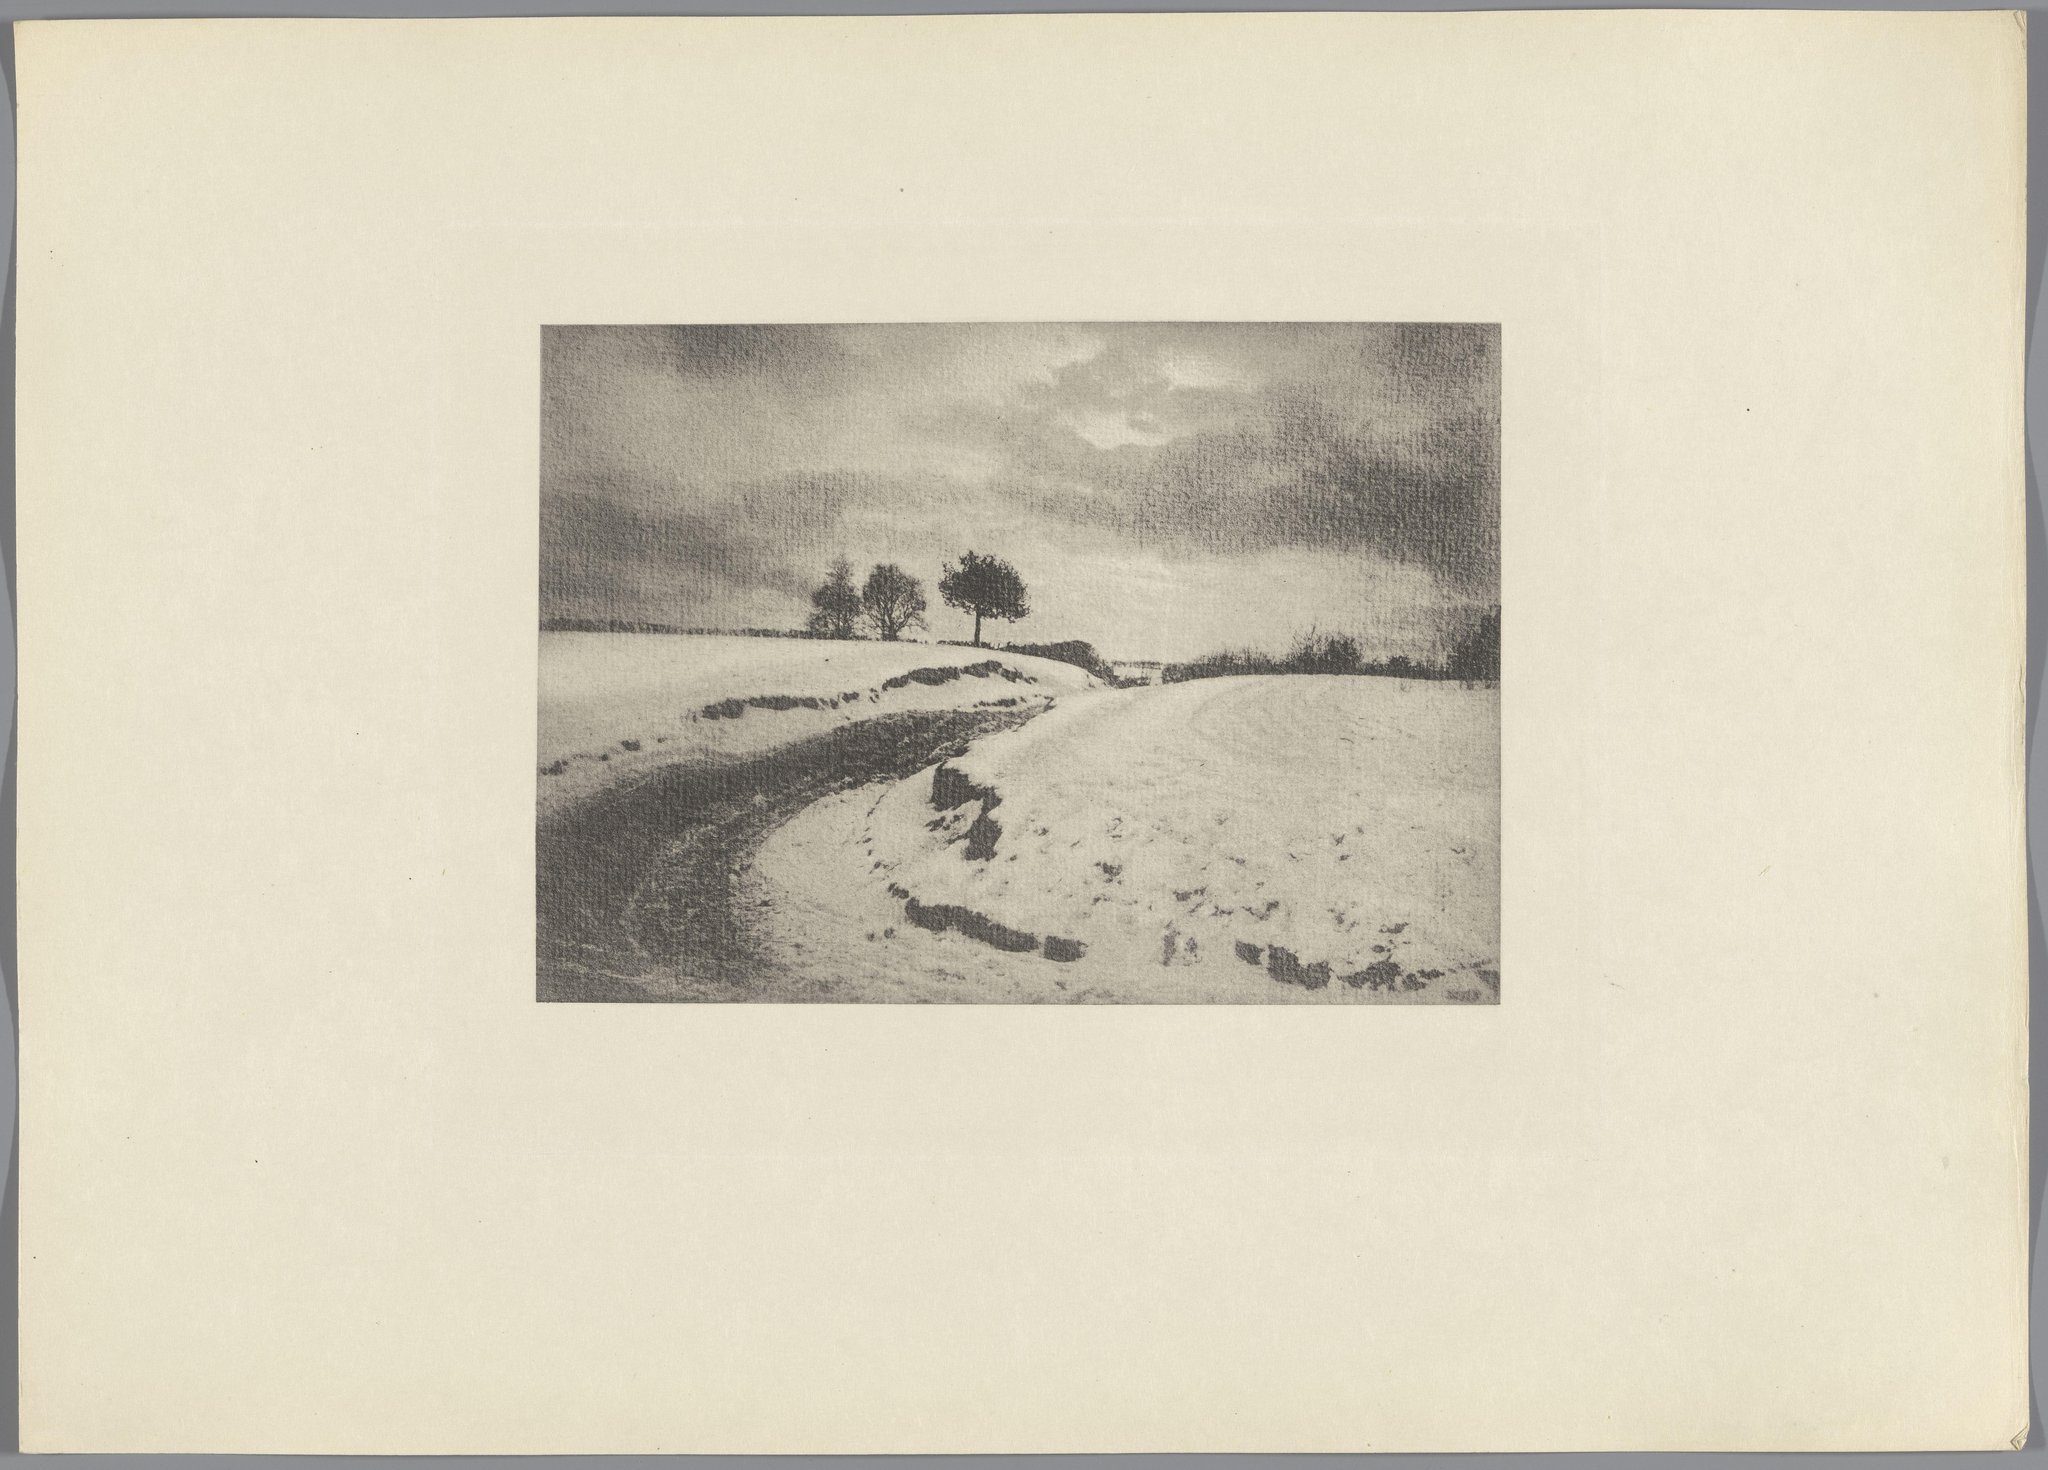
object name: photomechanical print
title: Landschap met landweg in de winter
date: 1891-1896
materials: paper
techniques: photoaquatint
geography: paris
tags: low hill country, road, path, winter landscape; landscape symbolizing winter (the four seasons of the year)